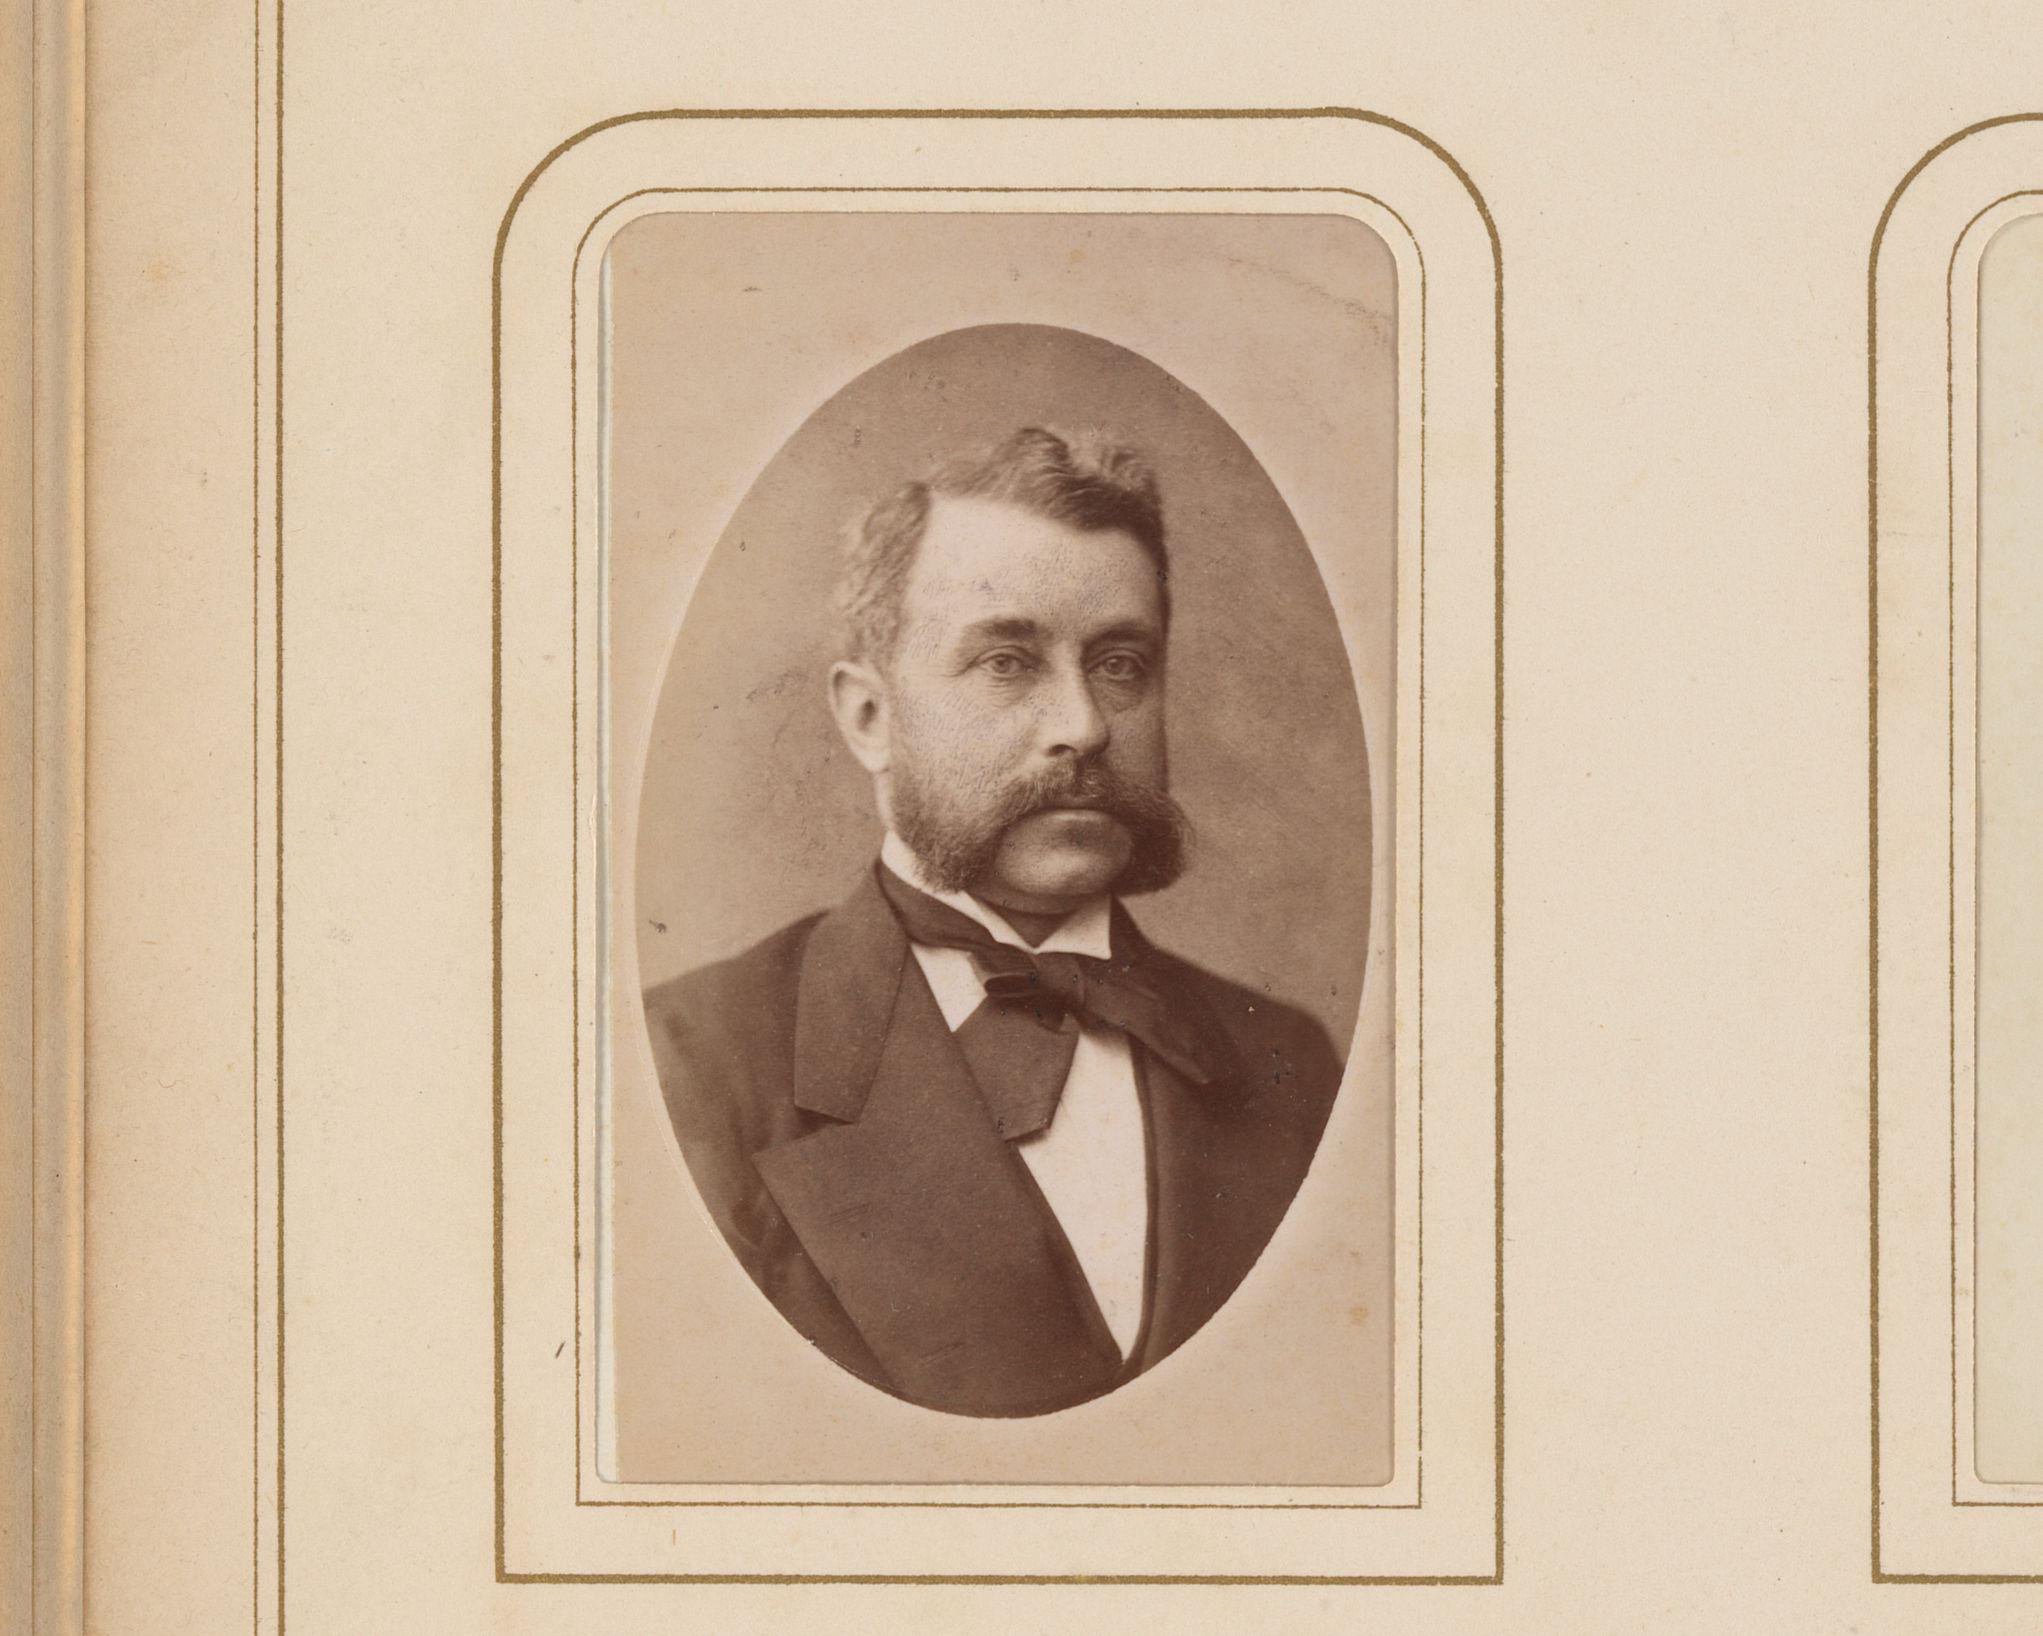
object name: album leaf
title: Portret van een man met snor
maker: jakob höflinger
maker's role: fotograaf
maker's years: 1819-1892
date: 1850-1892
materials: cardboard, photographic support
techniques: albumen print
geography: basel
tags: moustache, historical persons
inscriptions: annotation: ‘Ma[.]el[...]t’, inscription: ‘J. Höflinger/ BASEL/ Blumenrain No 32.’